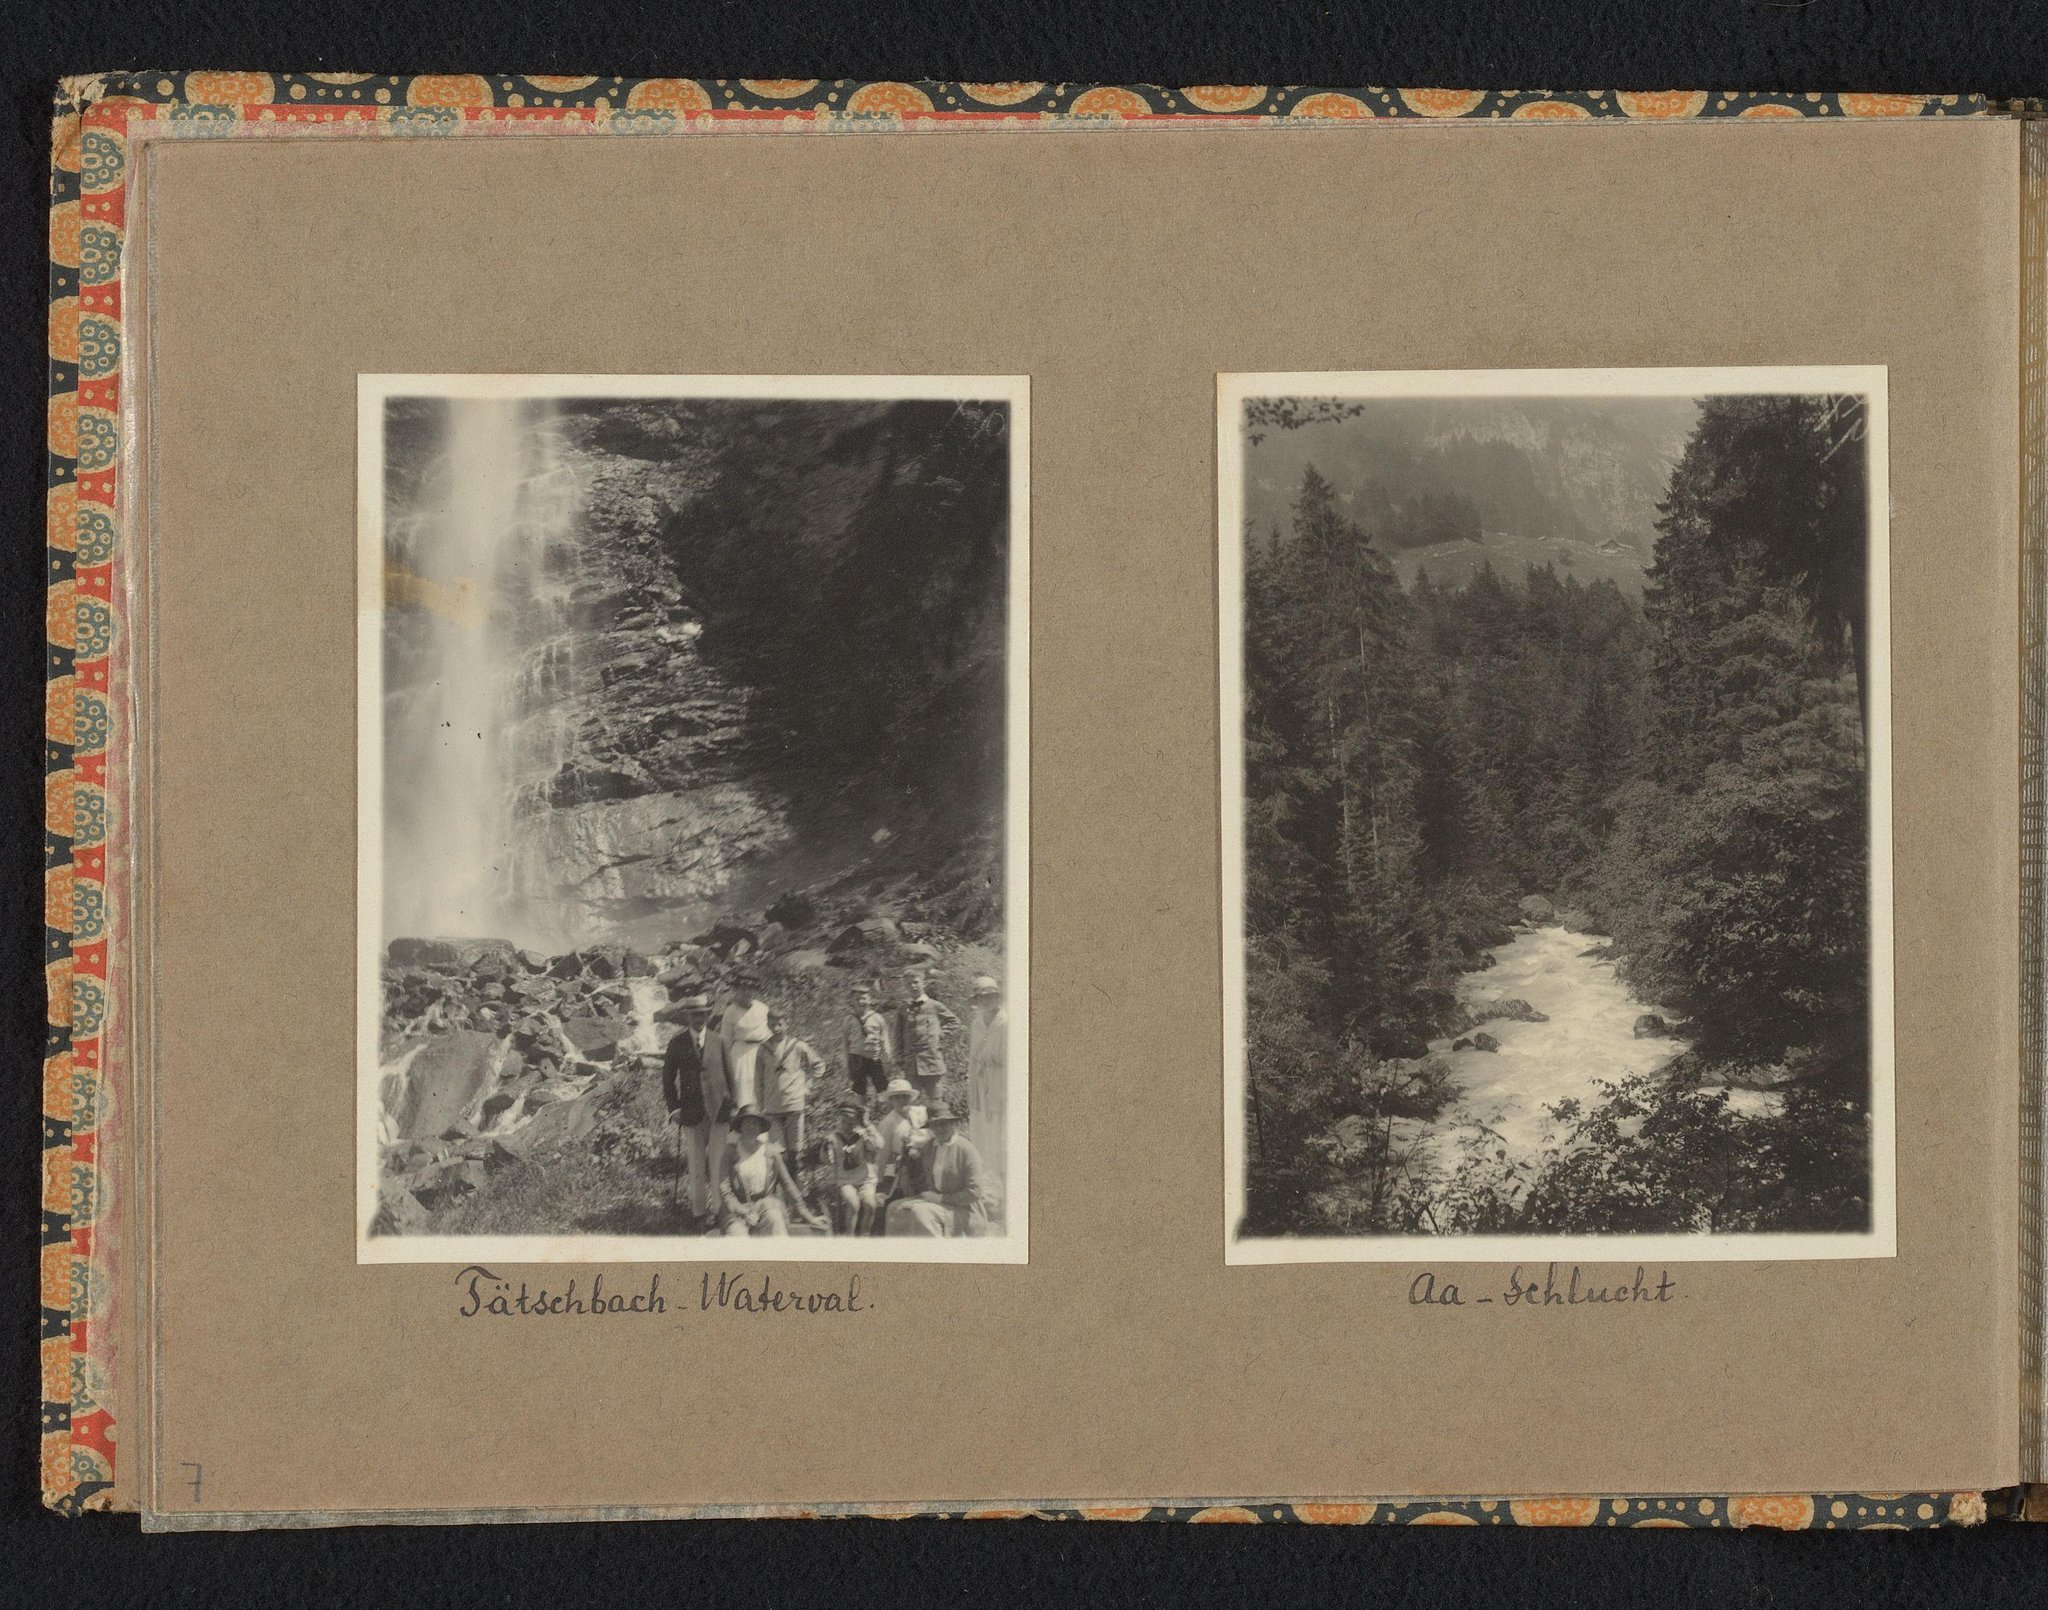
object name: album leaf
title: Twee foto's van familie Van den Berg bij de Tätschbach-waterval en een gezicht op de Aaschlucht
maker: hendrik herman van den berg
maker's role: amateurfotograaf, jurist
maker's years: 1875-1944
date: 1920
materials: paper, cardboard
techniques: gelatin silver print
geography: engelberg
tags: the hague, caroline louise van den berg-van den berg, carel frederik van den berg (cay), amsterdam, frank willem van den berg (1912-1998), walking, hiking (recreation), river, historical persons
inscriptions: caption: ‘Tätschbach-Waterval. Aa-Schlucht.’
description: Deze foto's maken deel uit van een album.